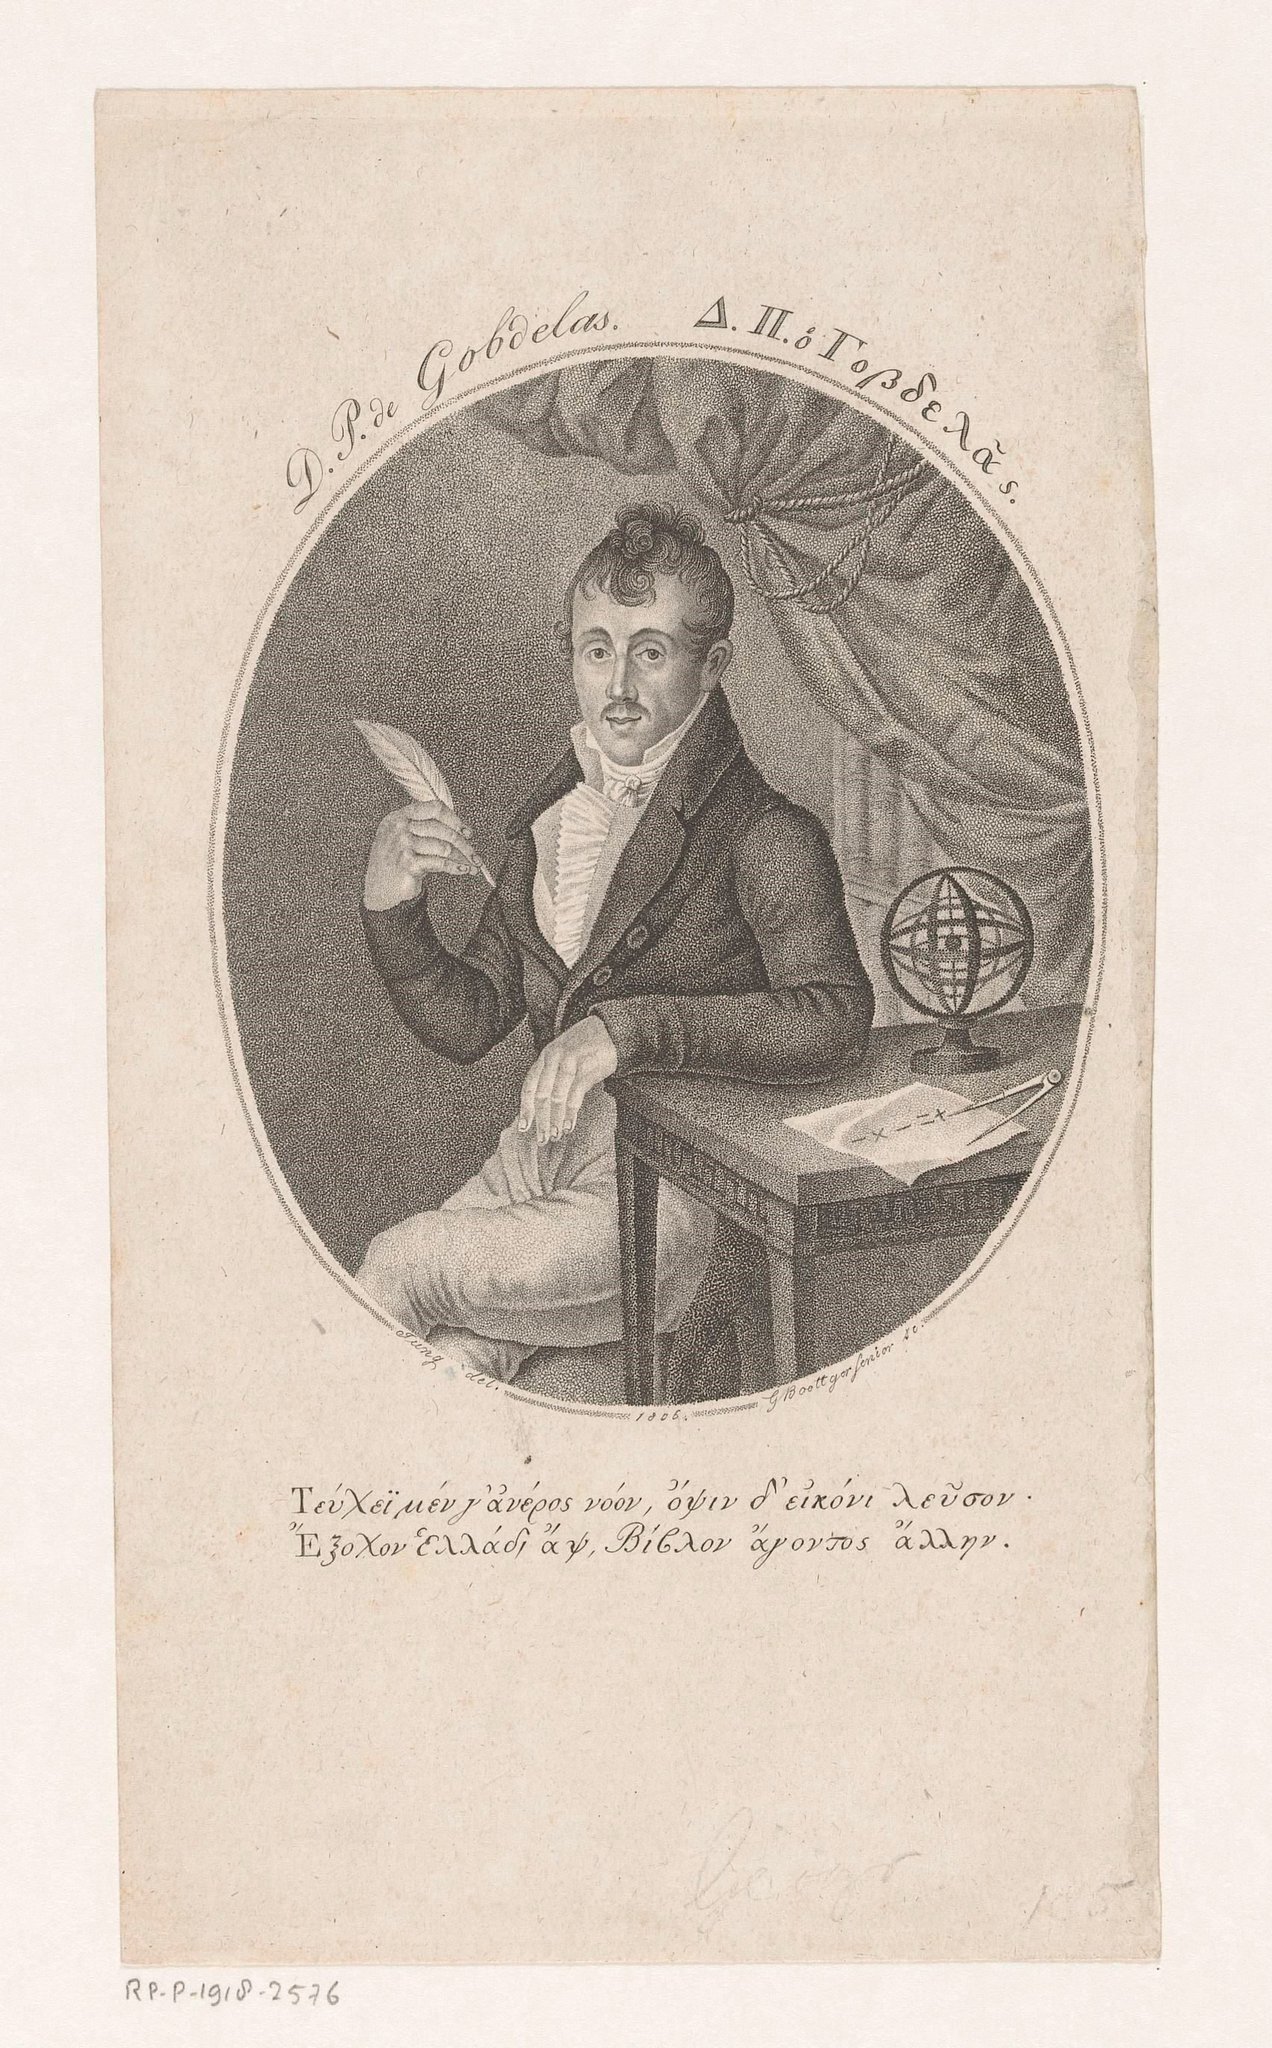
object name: print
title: Portret van Dēmētrios Gobdelas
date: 1806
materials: paper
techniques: etching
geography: nuremberg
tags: bookshelves, quill, historical persons, compasses, armillary sphere, skeleton celestial globe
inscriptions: collector's mark: Lugt 2228